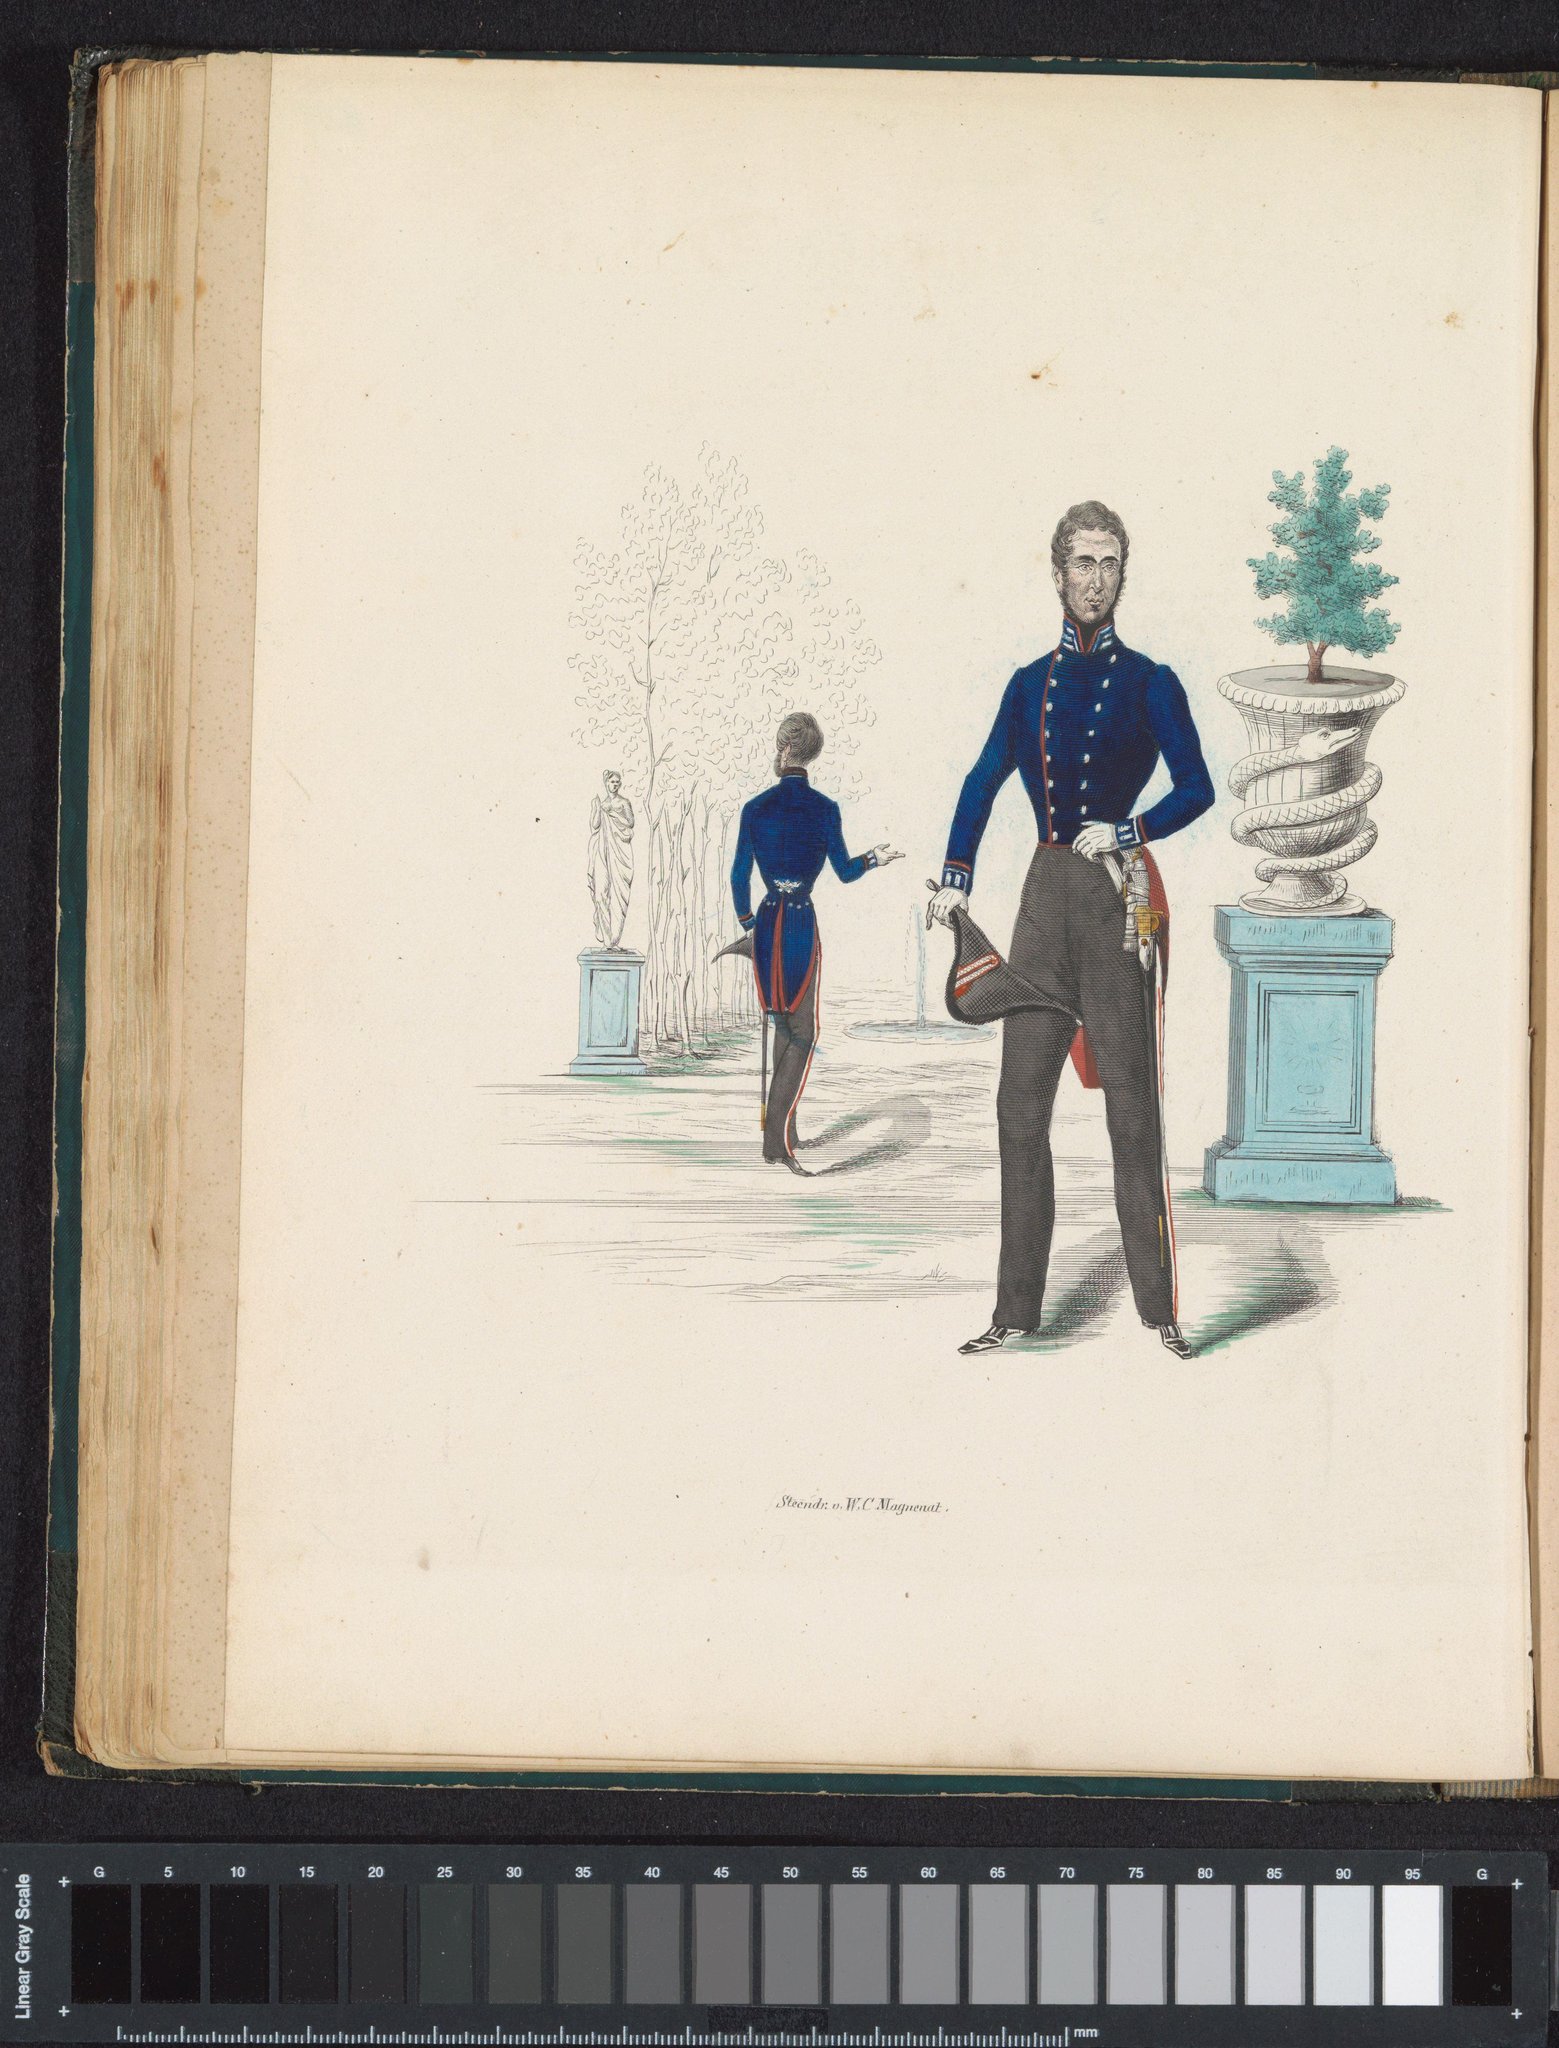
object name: book illustration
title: Geneeskundige Dienst. Apothekers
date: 1845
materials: paper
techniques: hand coloring, lithograph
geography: amsterdam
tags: (military) uniforms, netherlands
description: Uniform van apothekers van de Geneeskundige Dienst. Illustratie in een boek uit 1845 over de uniformen en kledingstukken van de Nederlandse land-, zeemacht en schutterijen in Nederland en in de overzeese gebiedsdelen.